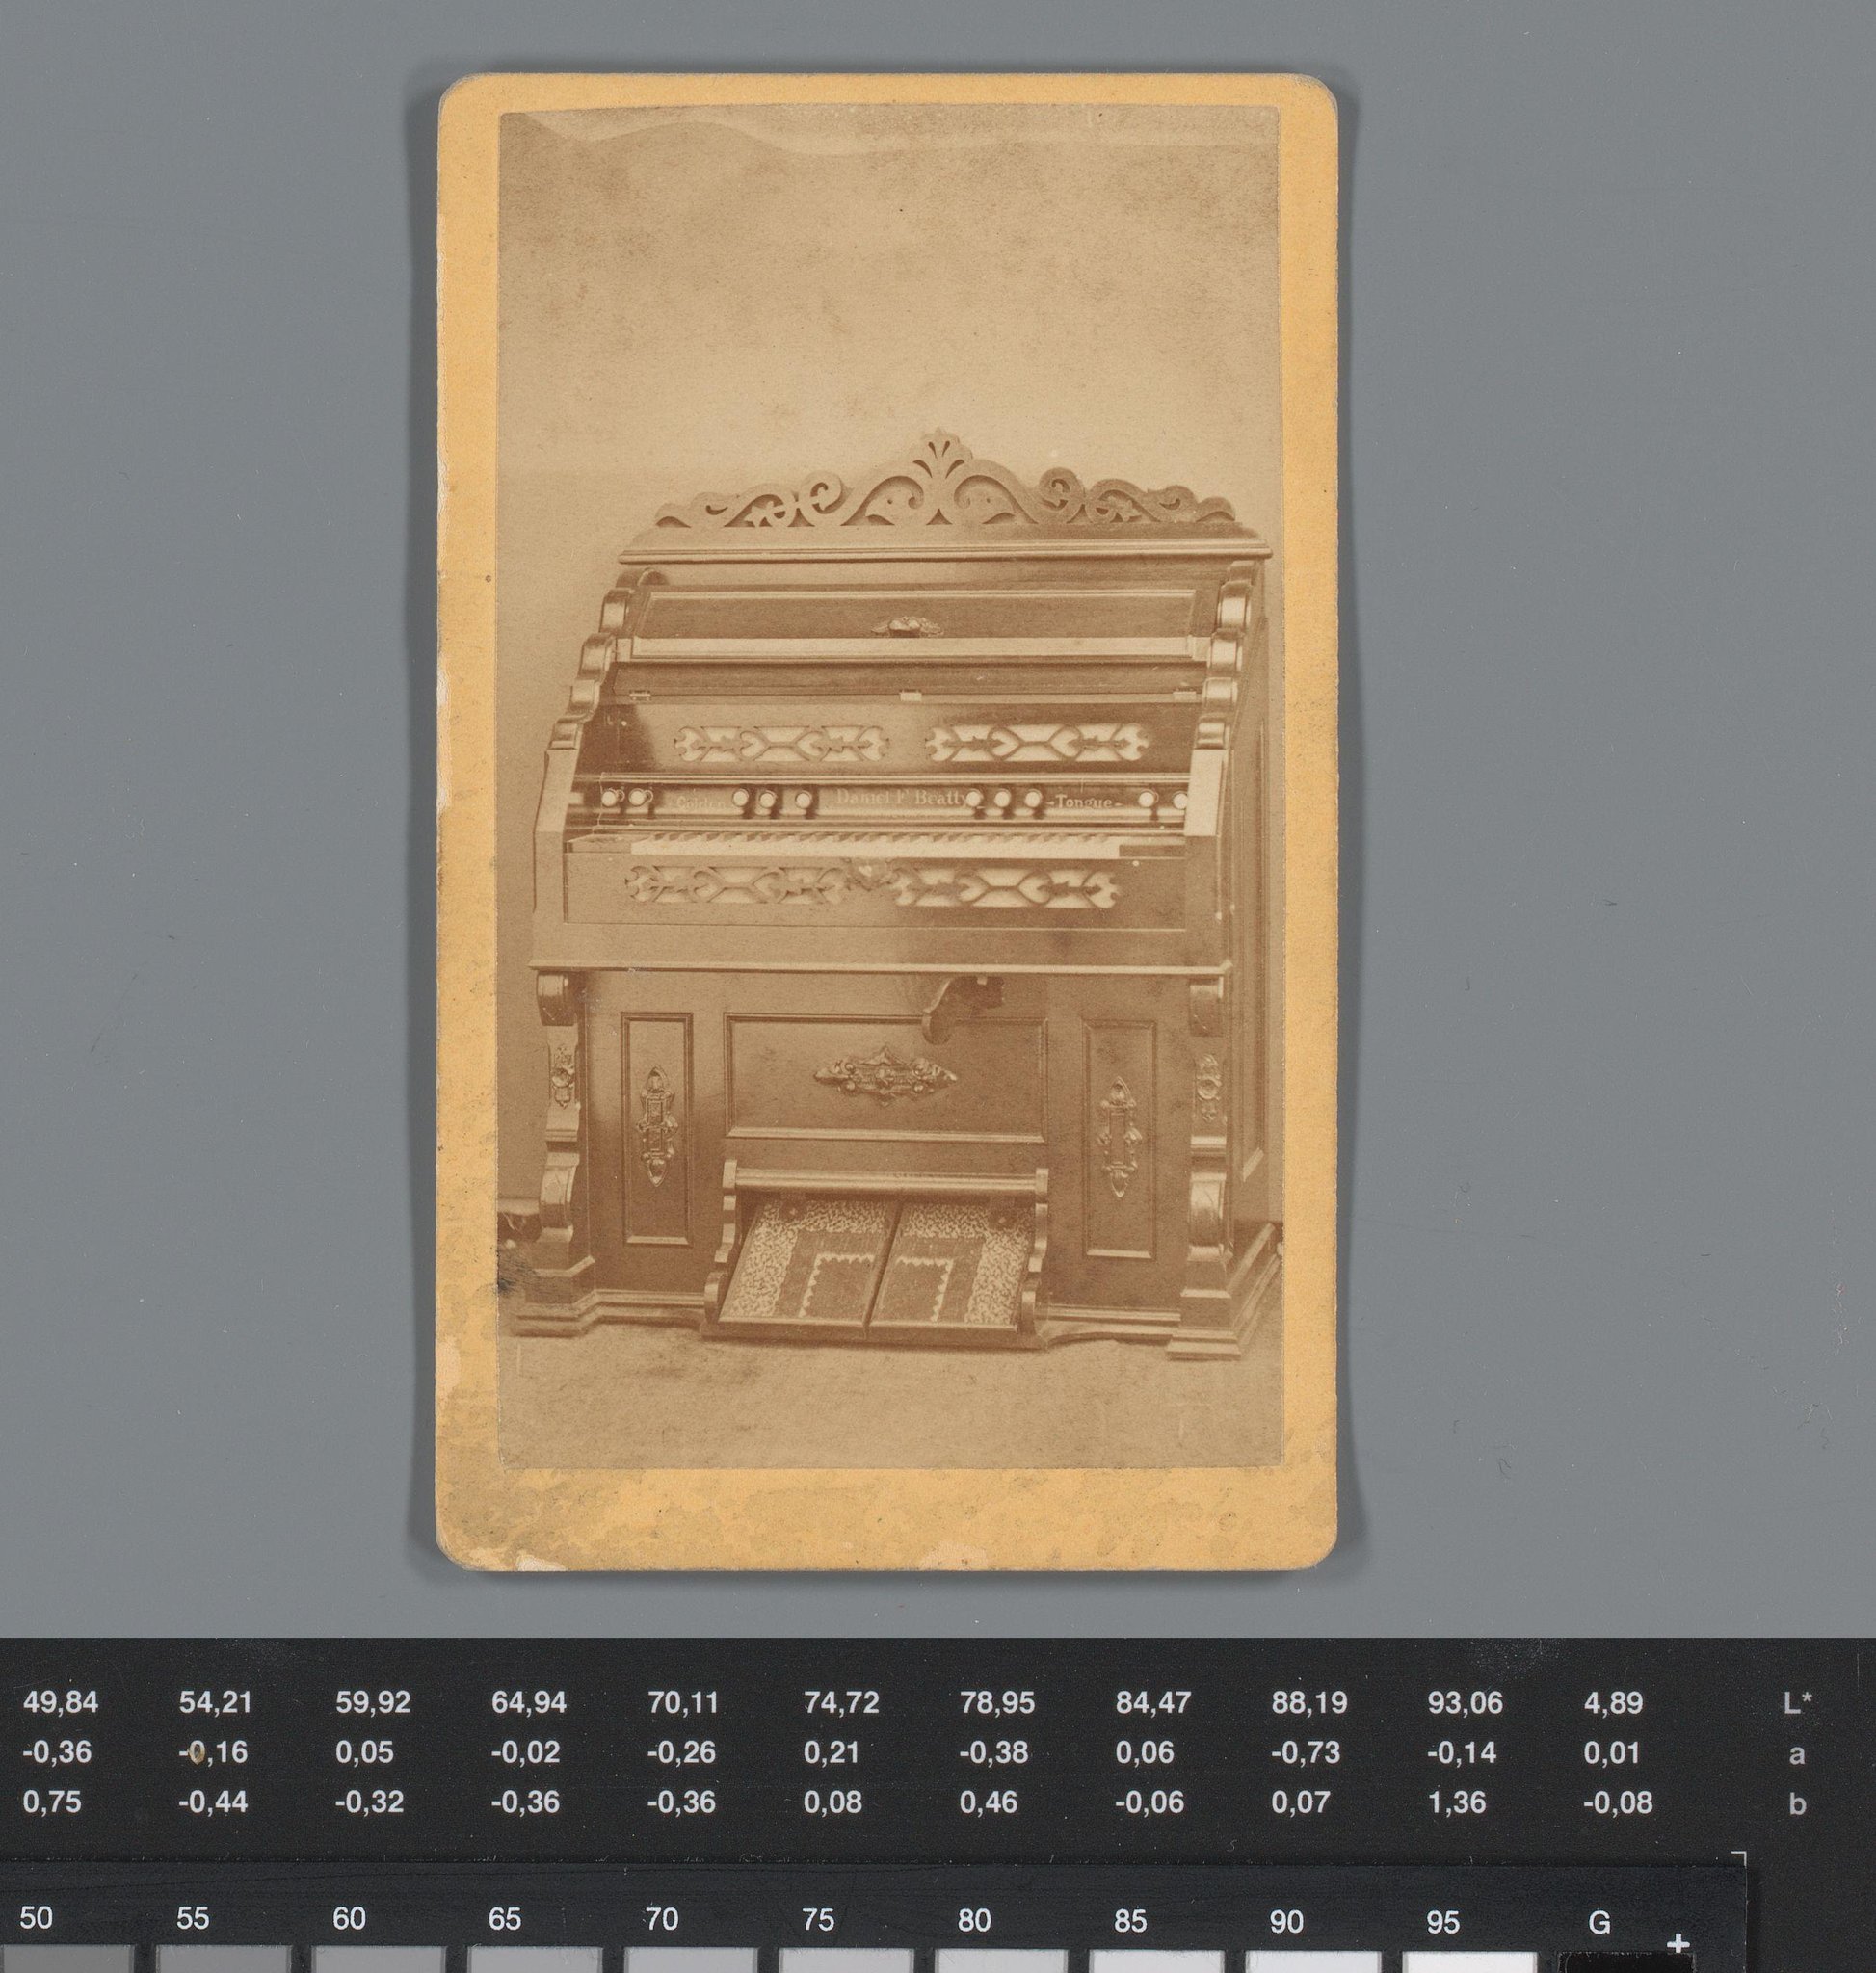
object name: carte de visite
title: Reclame voor orgels van Daniel F. Beatty te Corsicana, met gezicht op een orgel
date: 1850-1915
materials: cardboard, photographic support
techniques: albumen print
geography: texas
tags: advertising, organ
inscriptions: inscription: ‘DANNEL F. BEATTY'S / GOLDEN TONGUE / ORGAN. /(...)’